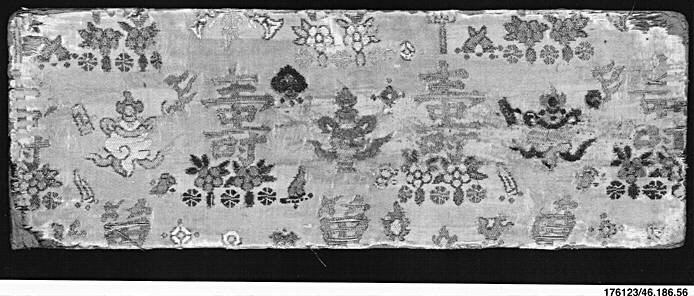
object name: sutra cover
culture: chinese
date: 1601-1700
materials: metal thread, silk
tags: human figures,flowers